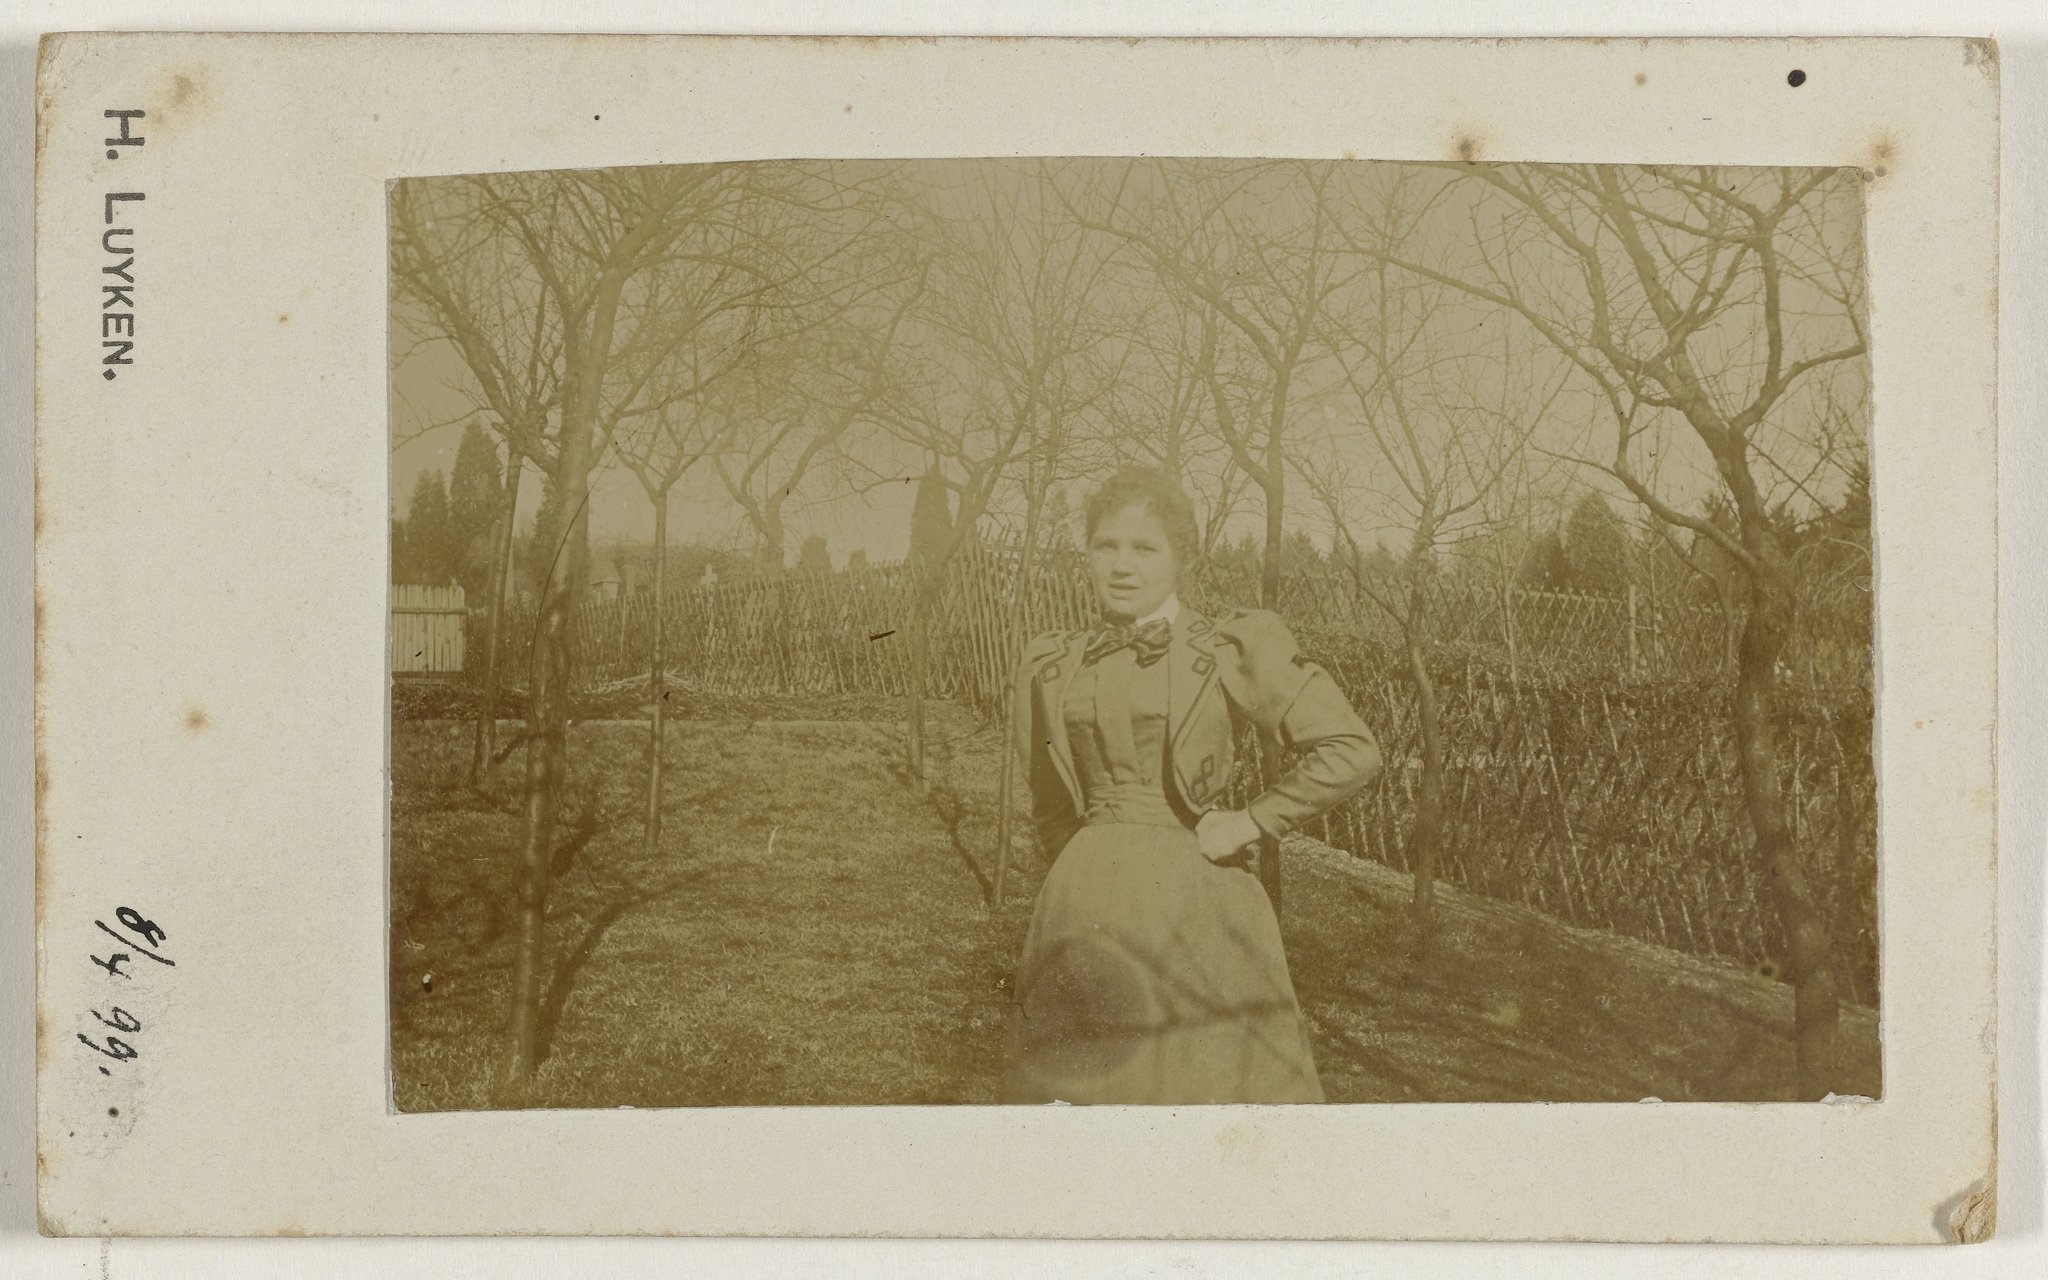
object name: carte de visite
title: Portret van een vrouw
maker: h. luyken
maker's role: fotograaf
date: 1899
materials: cardboard, paper, photographic support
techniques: albumen print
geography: london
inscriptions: date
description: Staande vrouw, buiten, met hekken en bomen op de achtergrond.